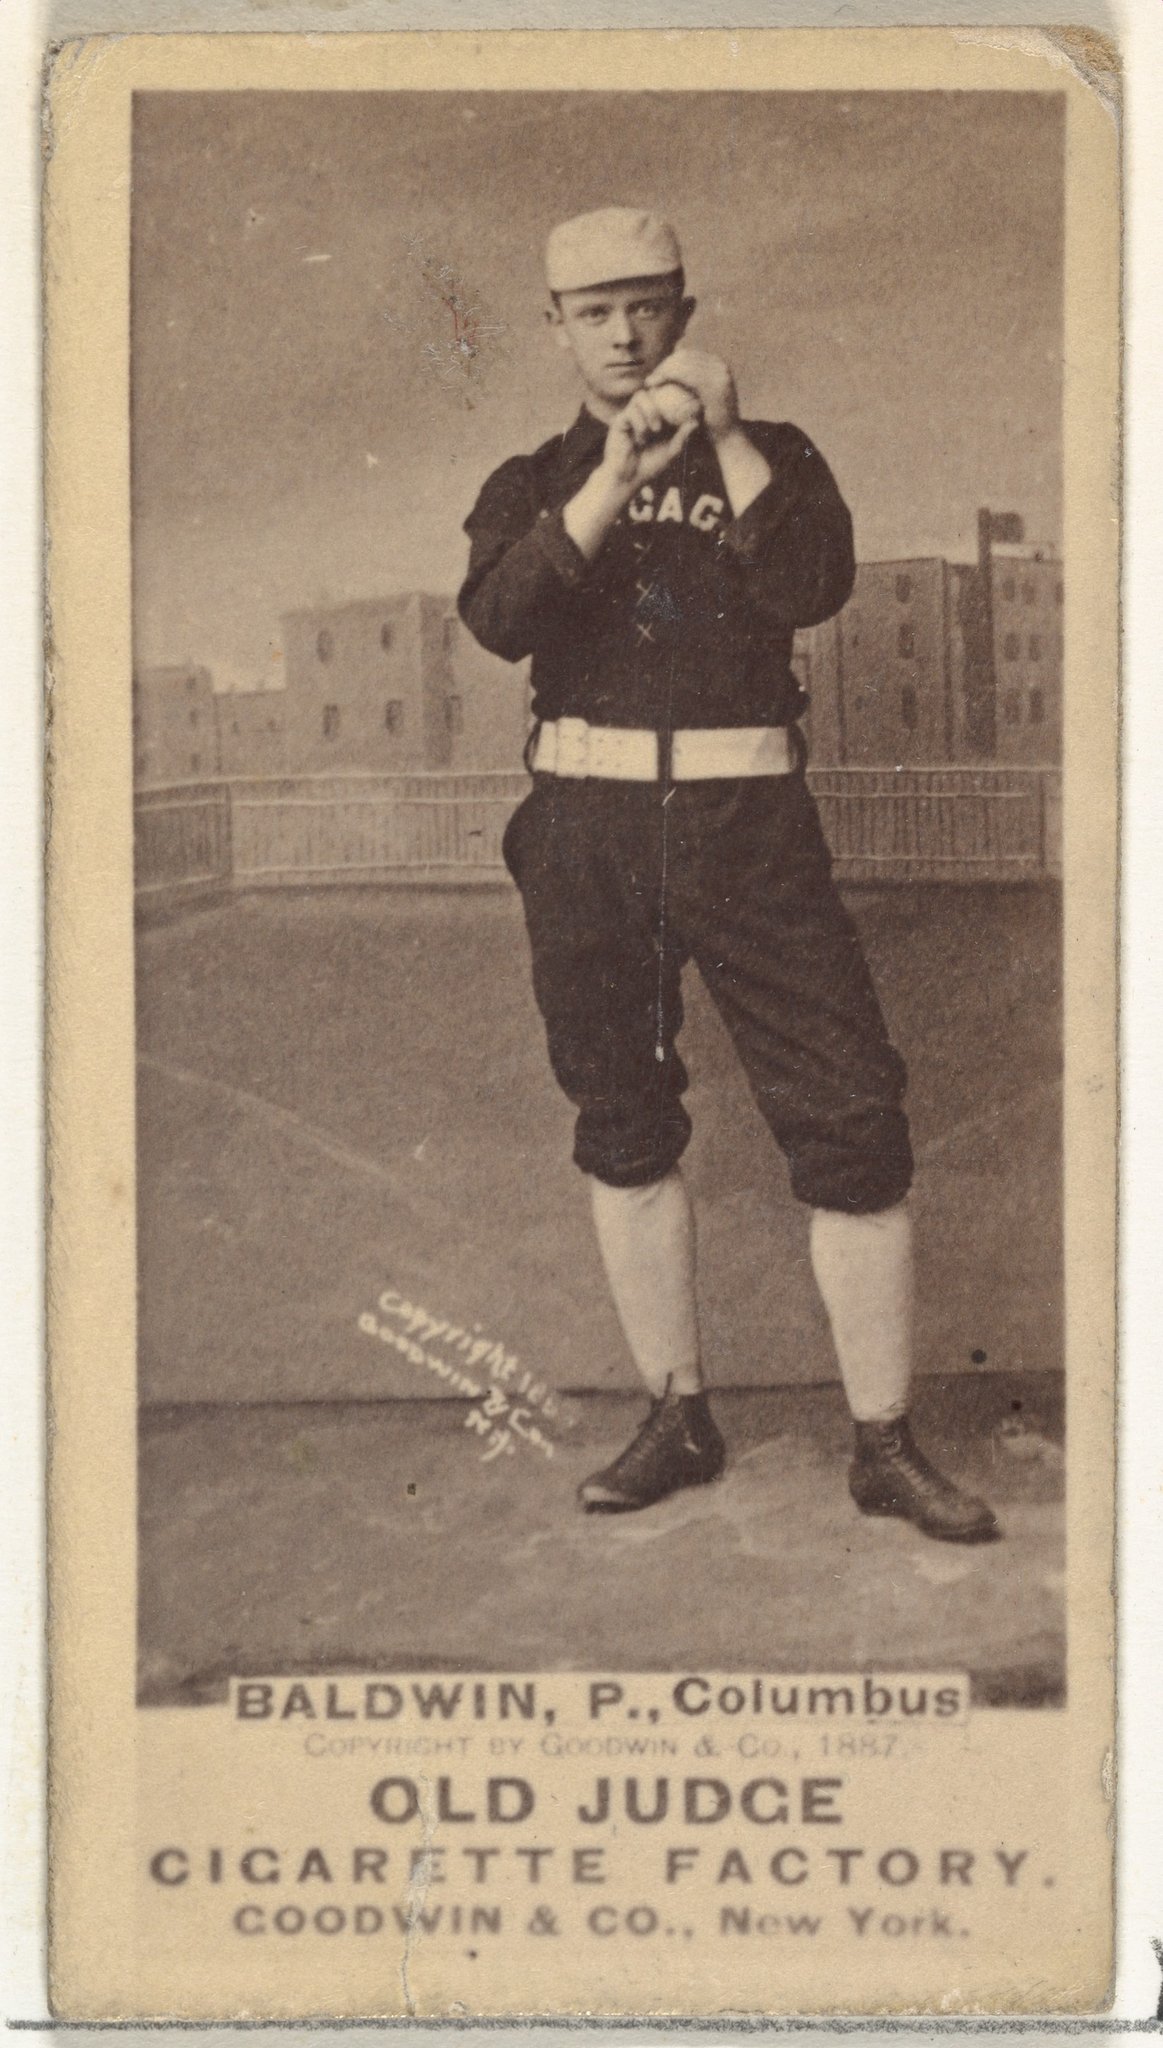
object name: baseball card, photograph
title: Marcus Elmore "Fido" Baldwin, Pitcher, Cleveland, from the Old Judge series (N172) for Old Judge Cigarettes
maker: goodwin & company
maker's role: publisher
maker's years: 1850-1950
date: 1887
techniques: albumen silver print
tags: men,profiles,baseball,athletes